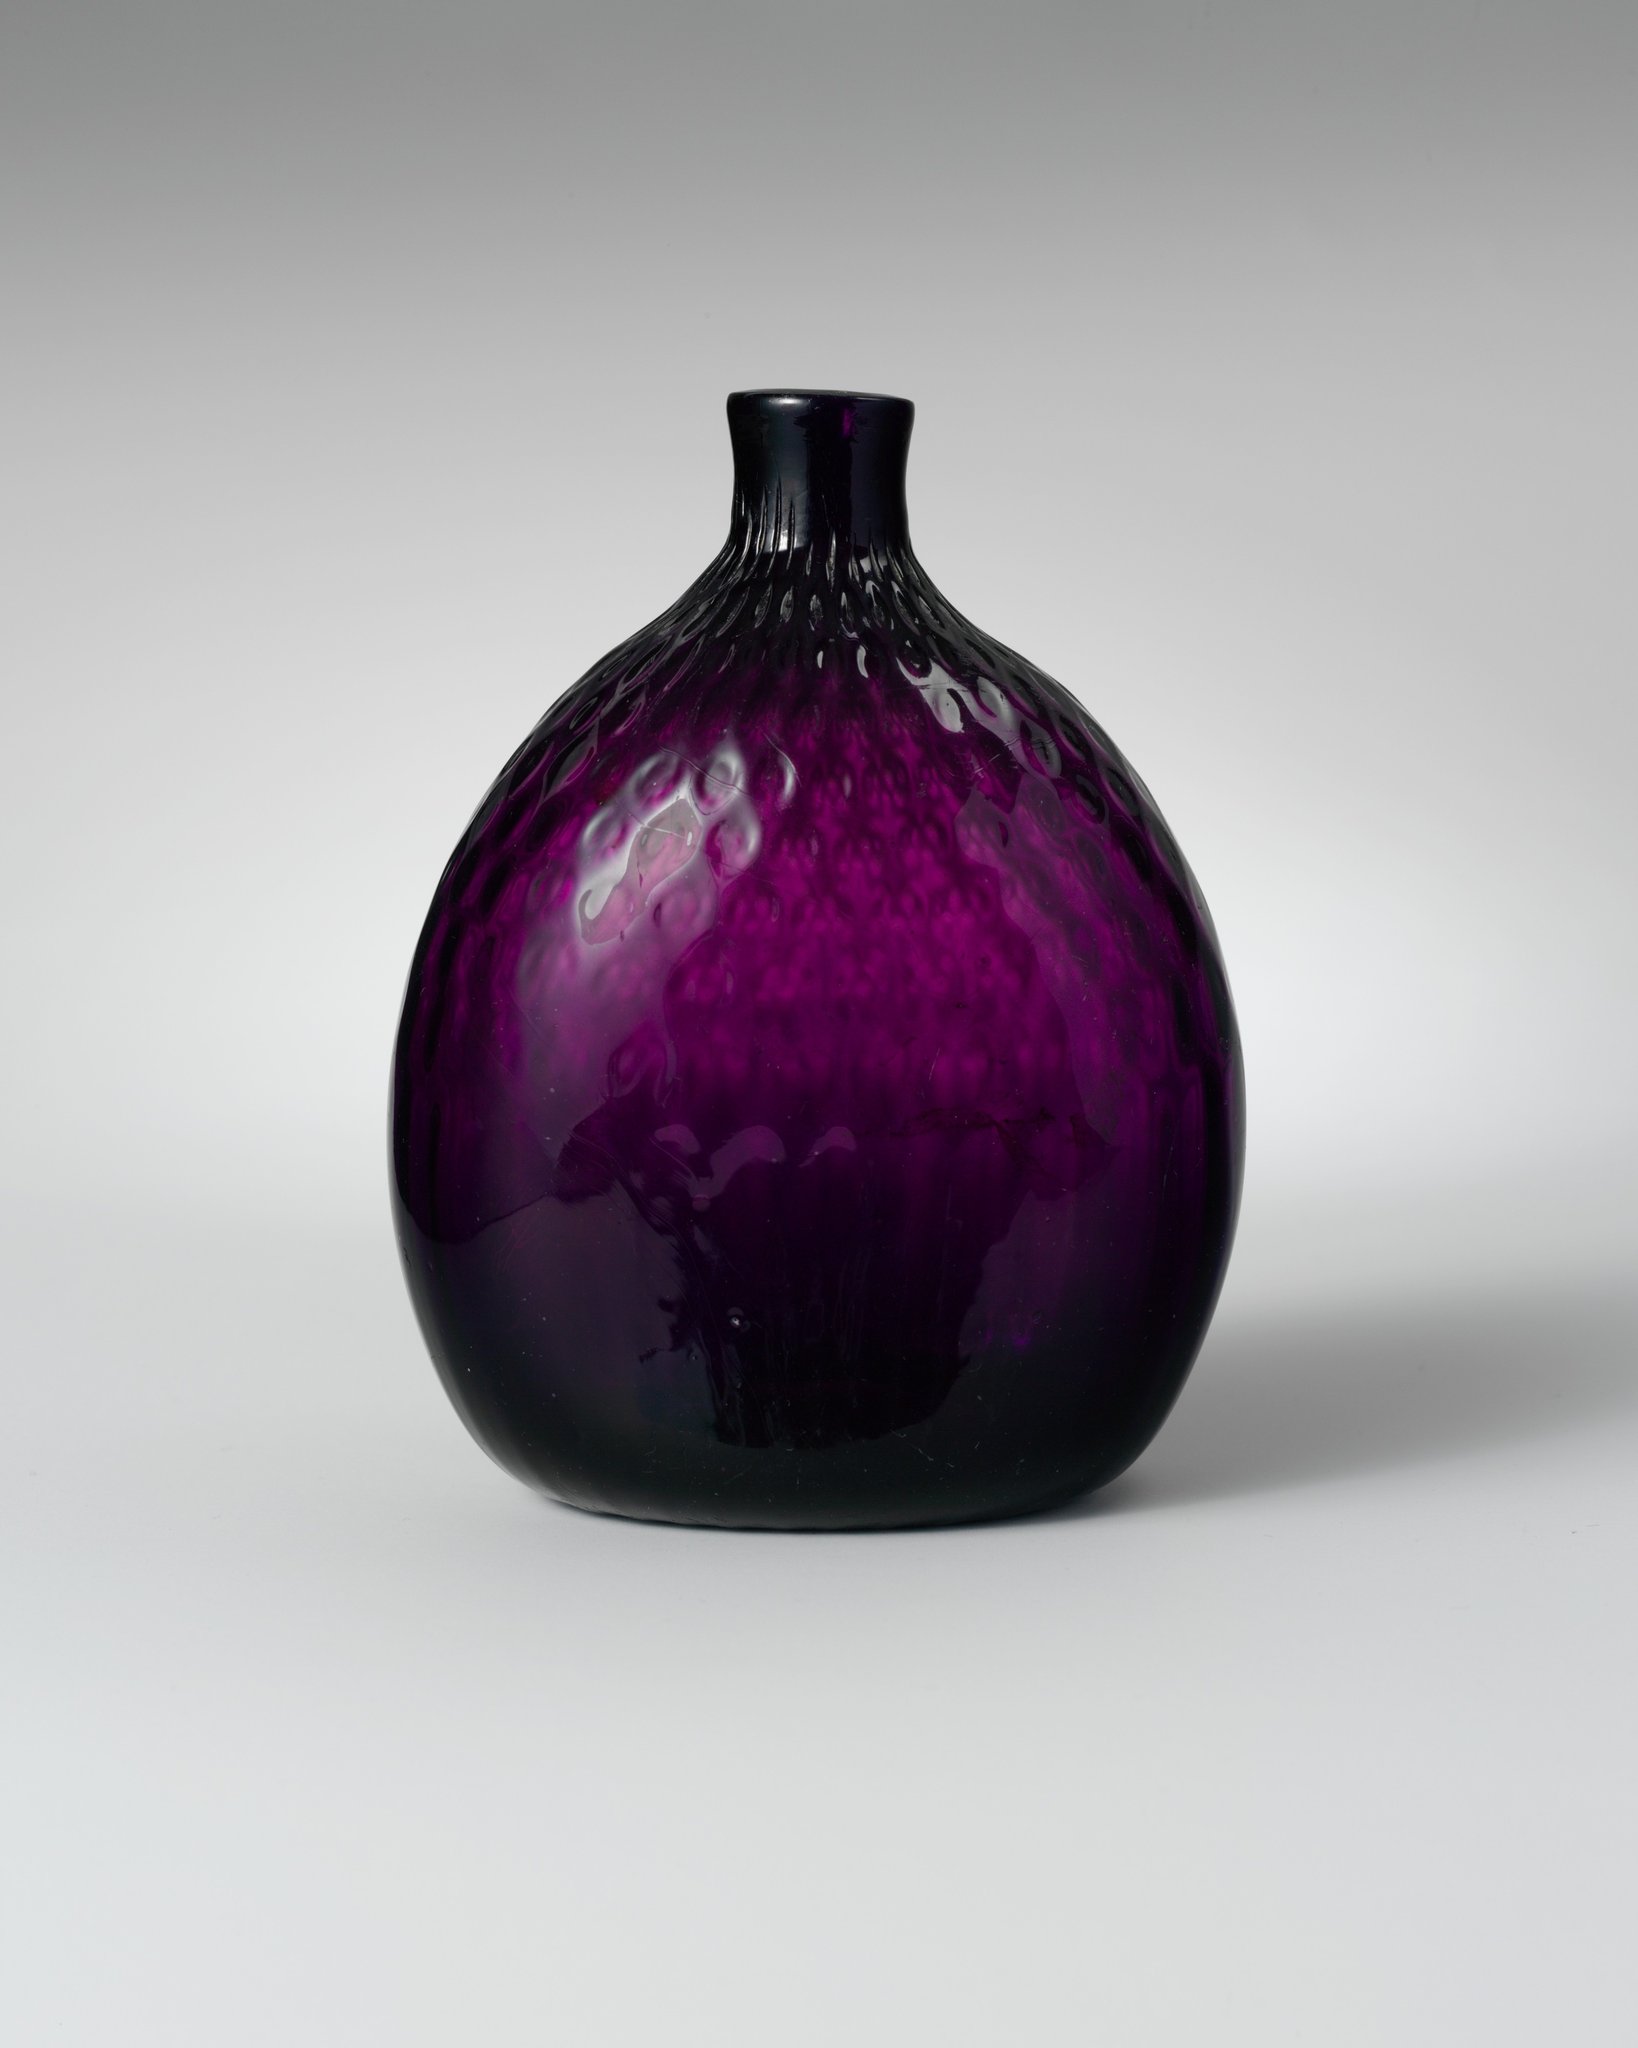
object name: flask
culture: american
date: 1770-1880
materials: glass, lead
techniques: glassblowing, molding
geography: united states